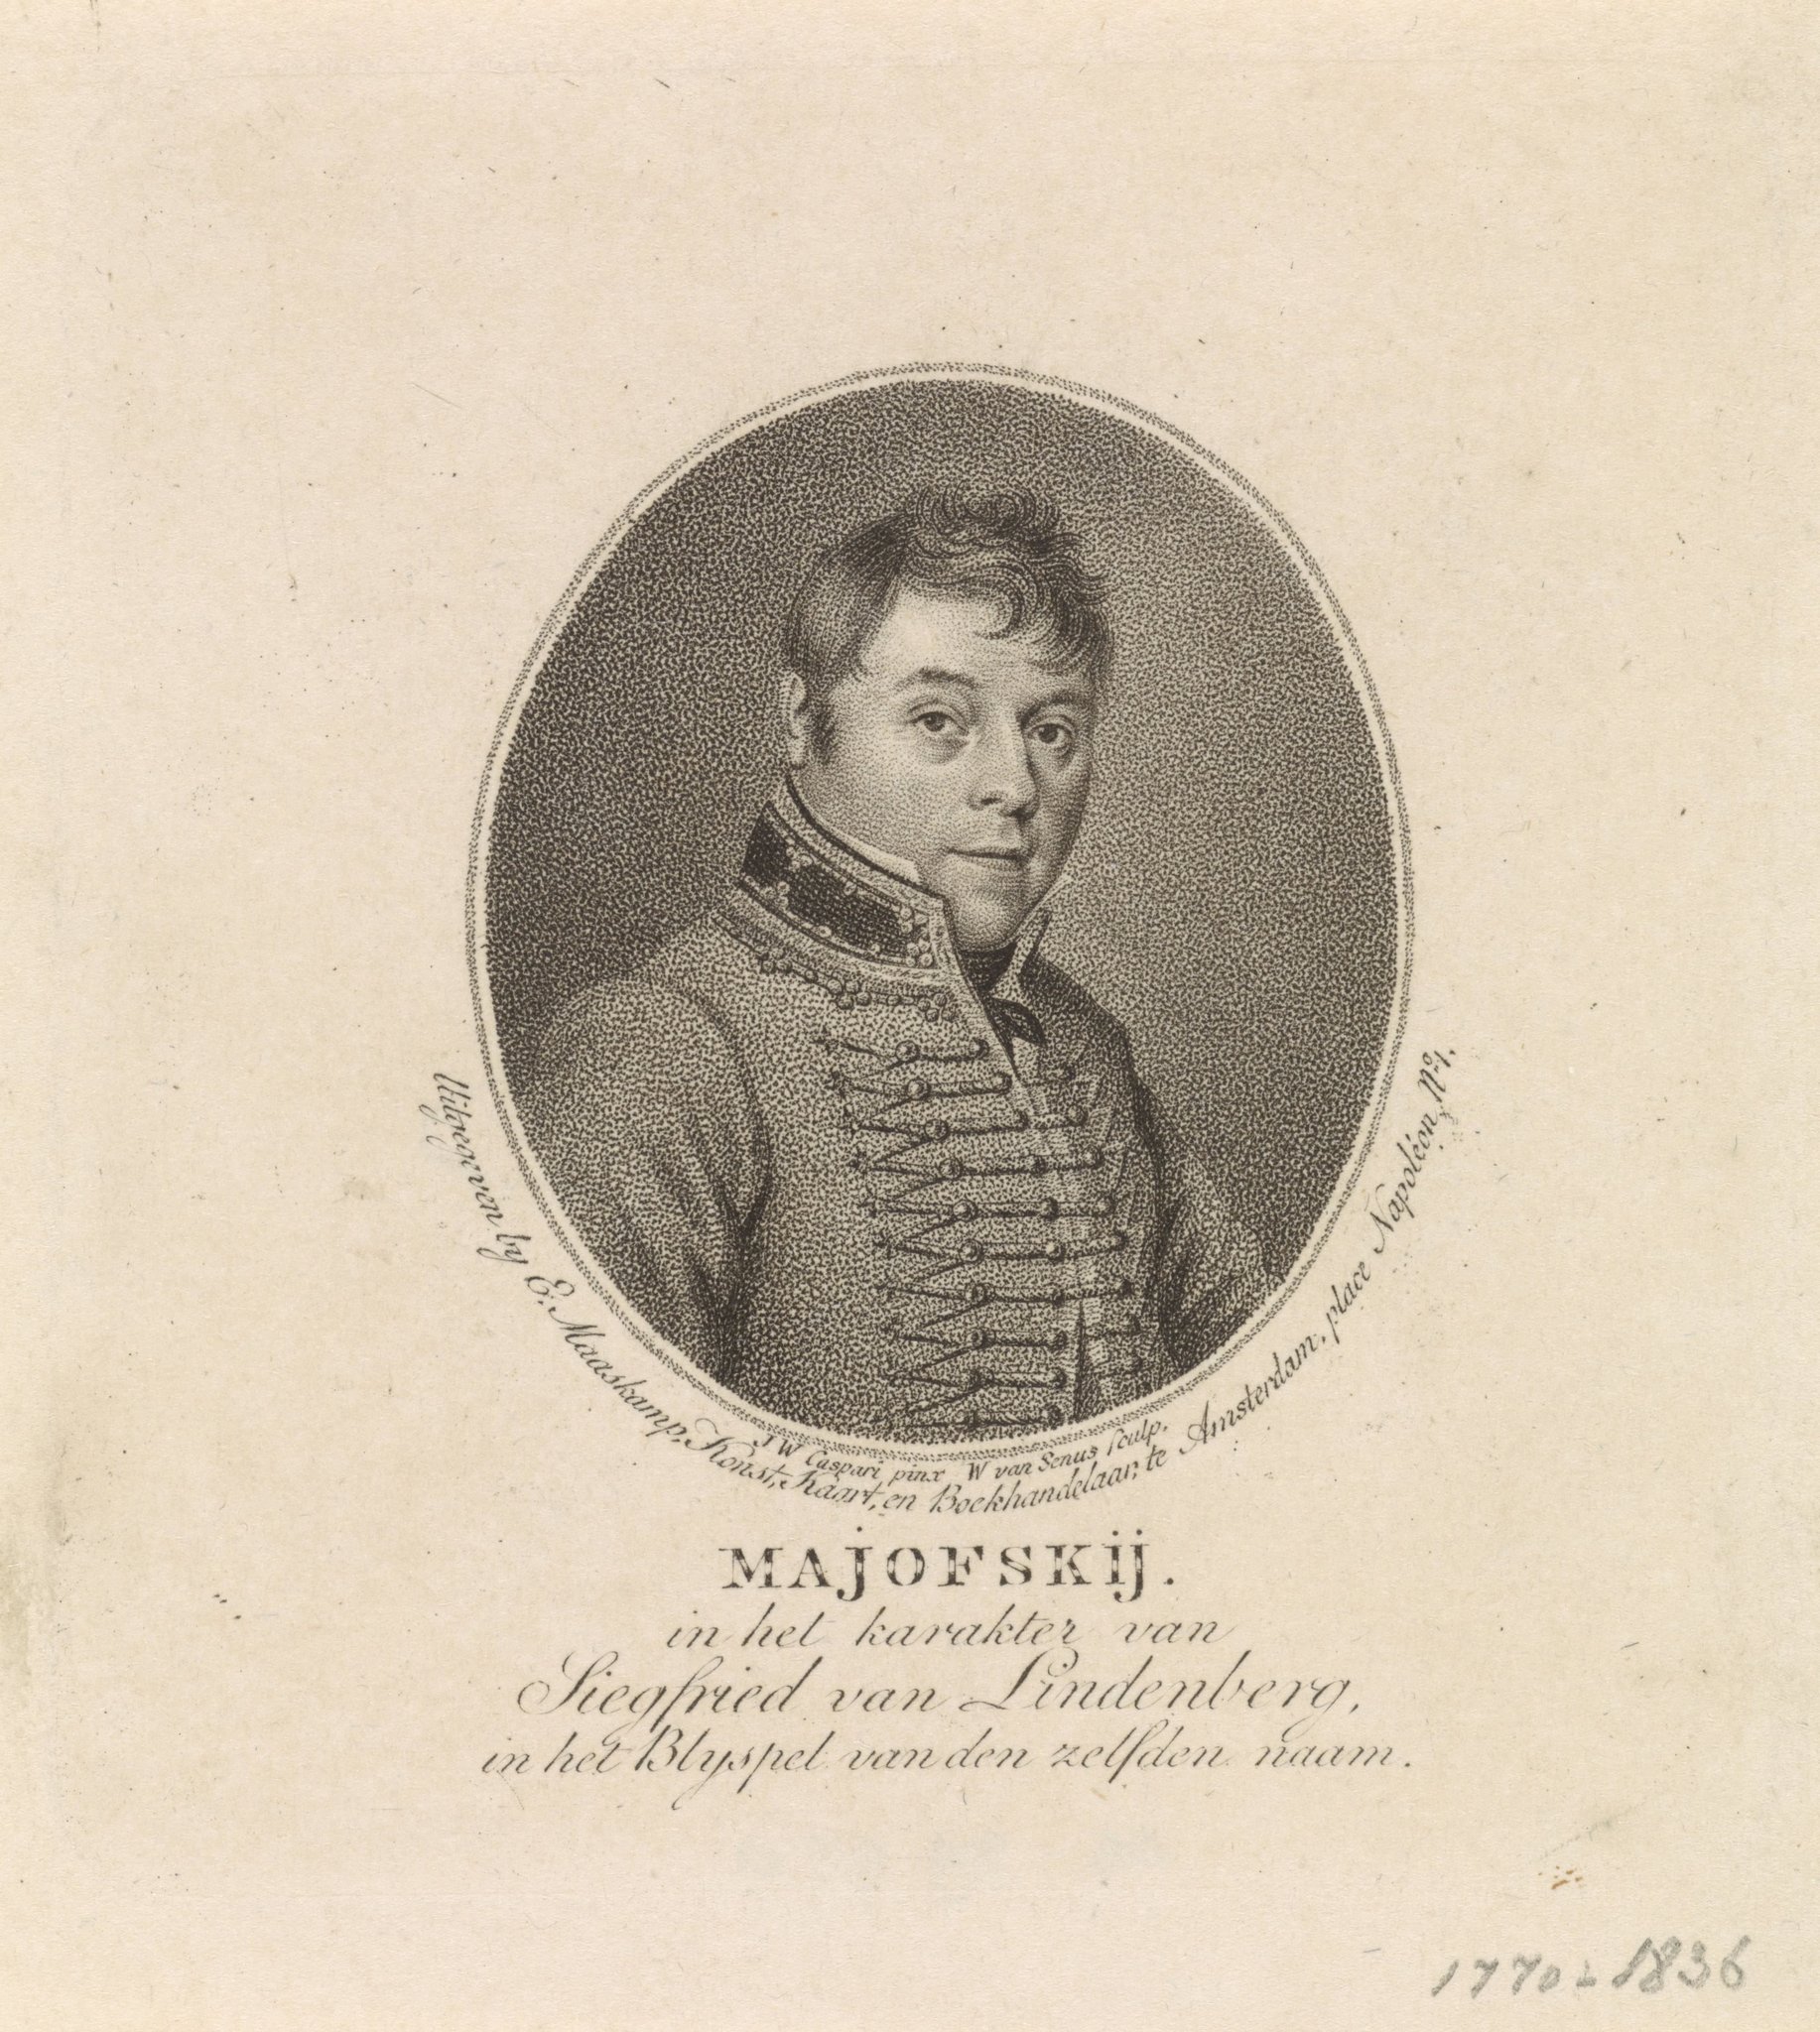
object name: print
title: Spelers aan de Stadsschouwburg te Amsterdam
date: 1788-1851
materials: paper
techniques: etching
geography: amsterdam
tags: leiden, amsterdam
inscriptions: collector's mark: Lugt 2228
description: Portret van de toneelspeler Theo Majofski, in de rol van Siegfried van Lindenberg, uit het gelijknamige toneelstuk van de toneelschrijver Johann Gottwerth Mülle.